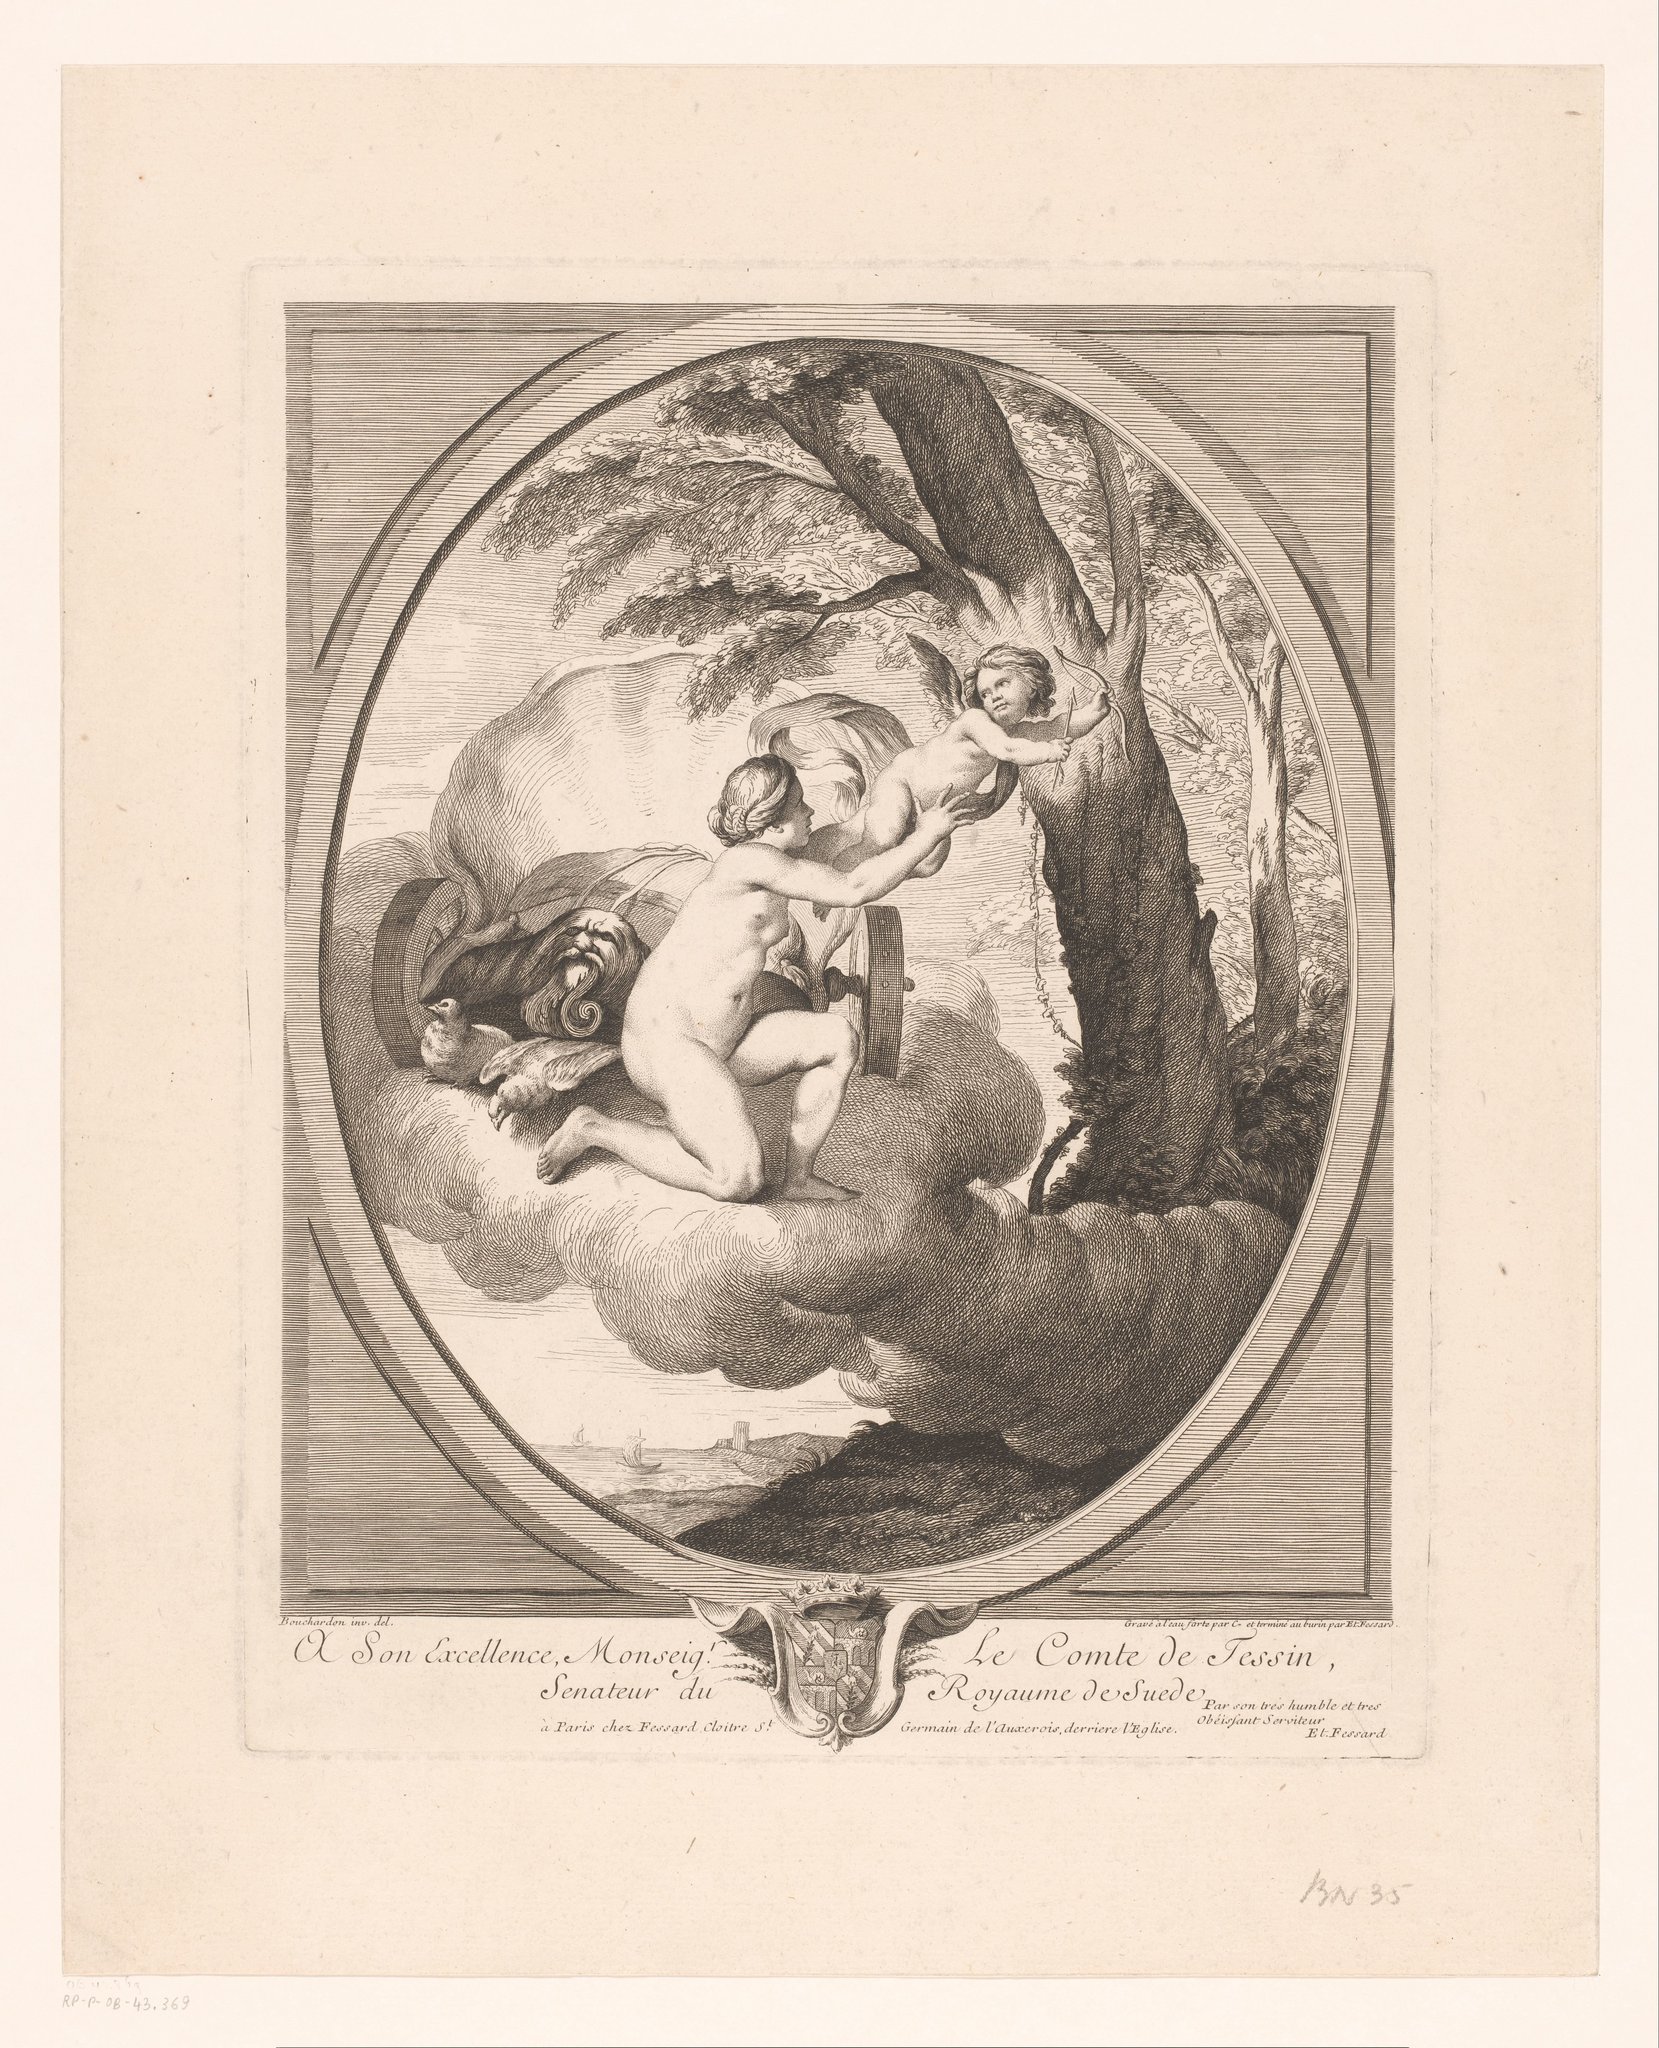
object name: print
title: Venus behoedt Amor voor de jacht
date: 1724-1777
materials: paper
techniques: engraving, etching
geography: france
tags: venus trying to prevent adonis from going hunting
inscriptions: collector's mark: Lugt 240